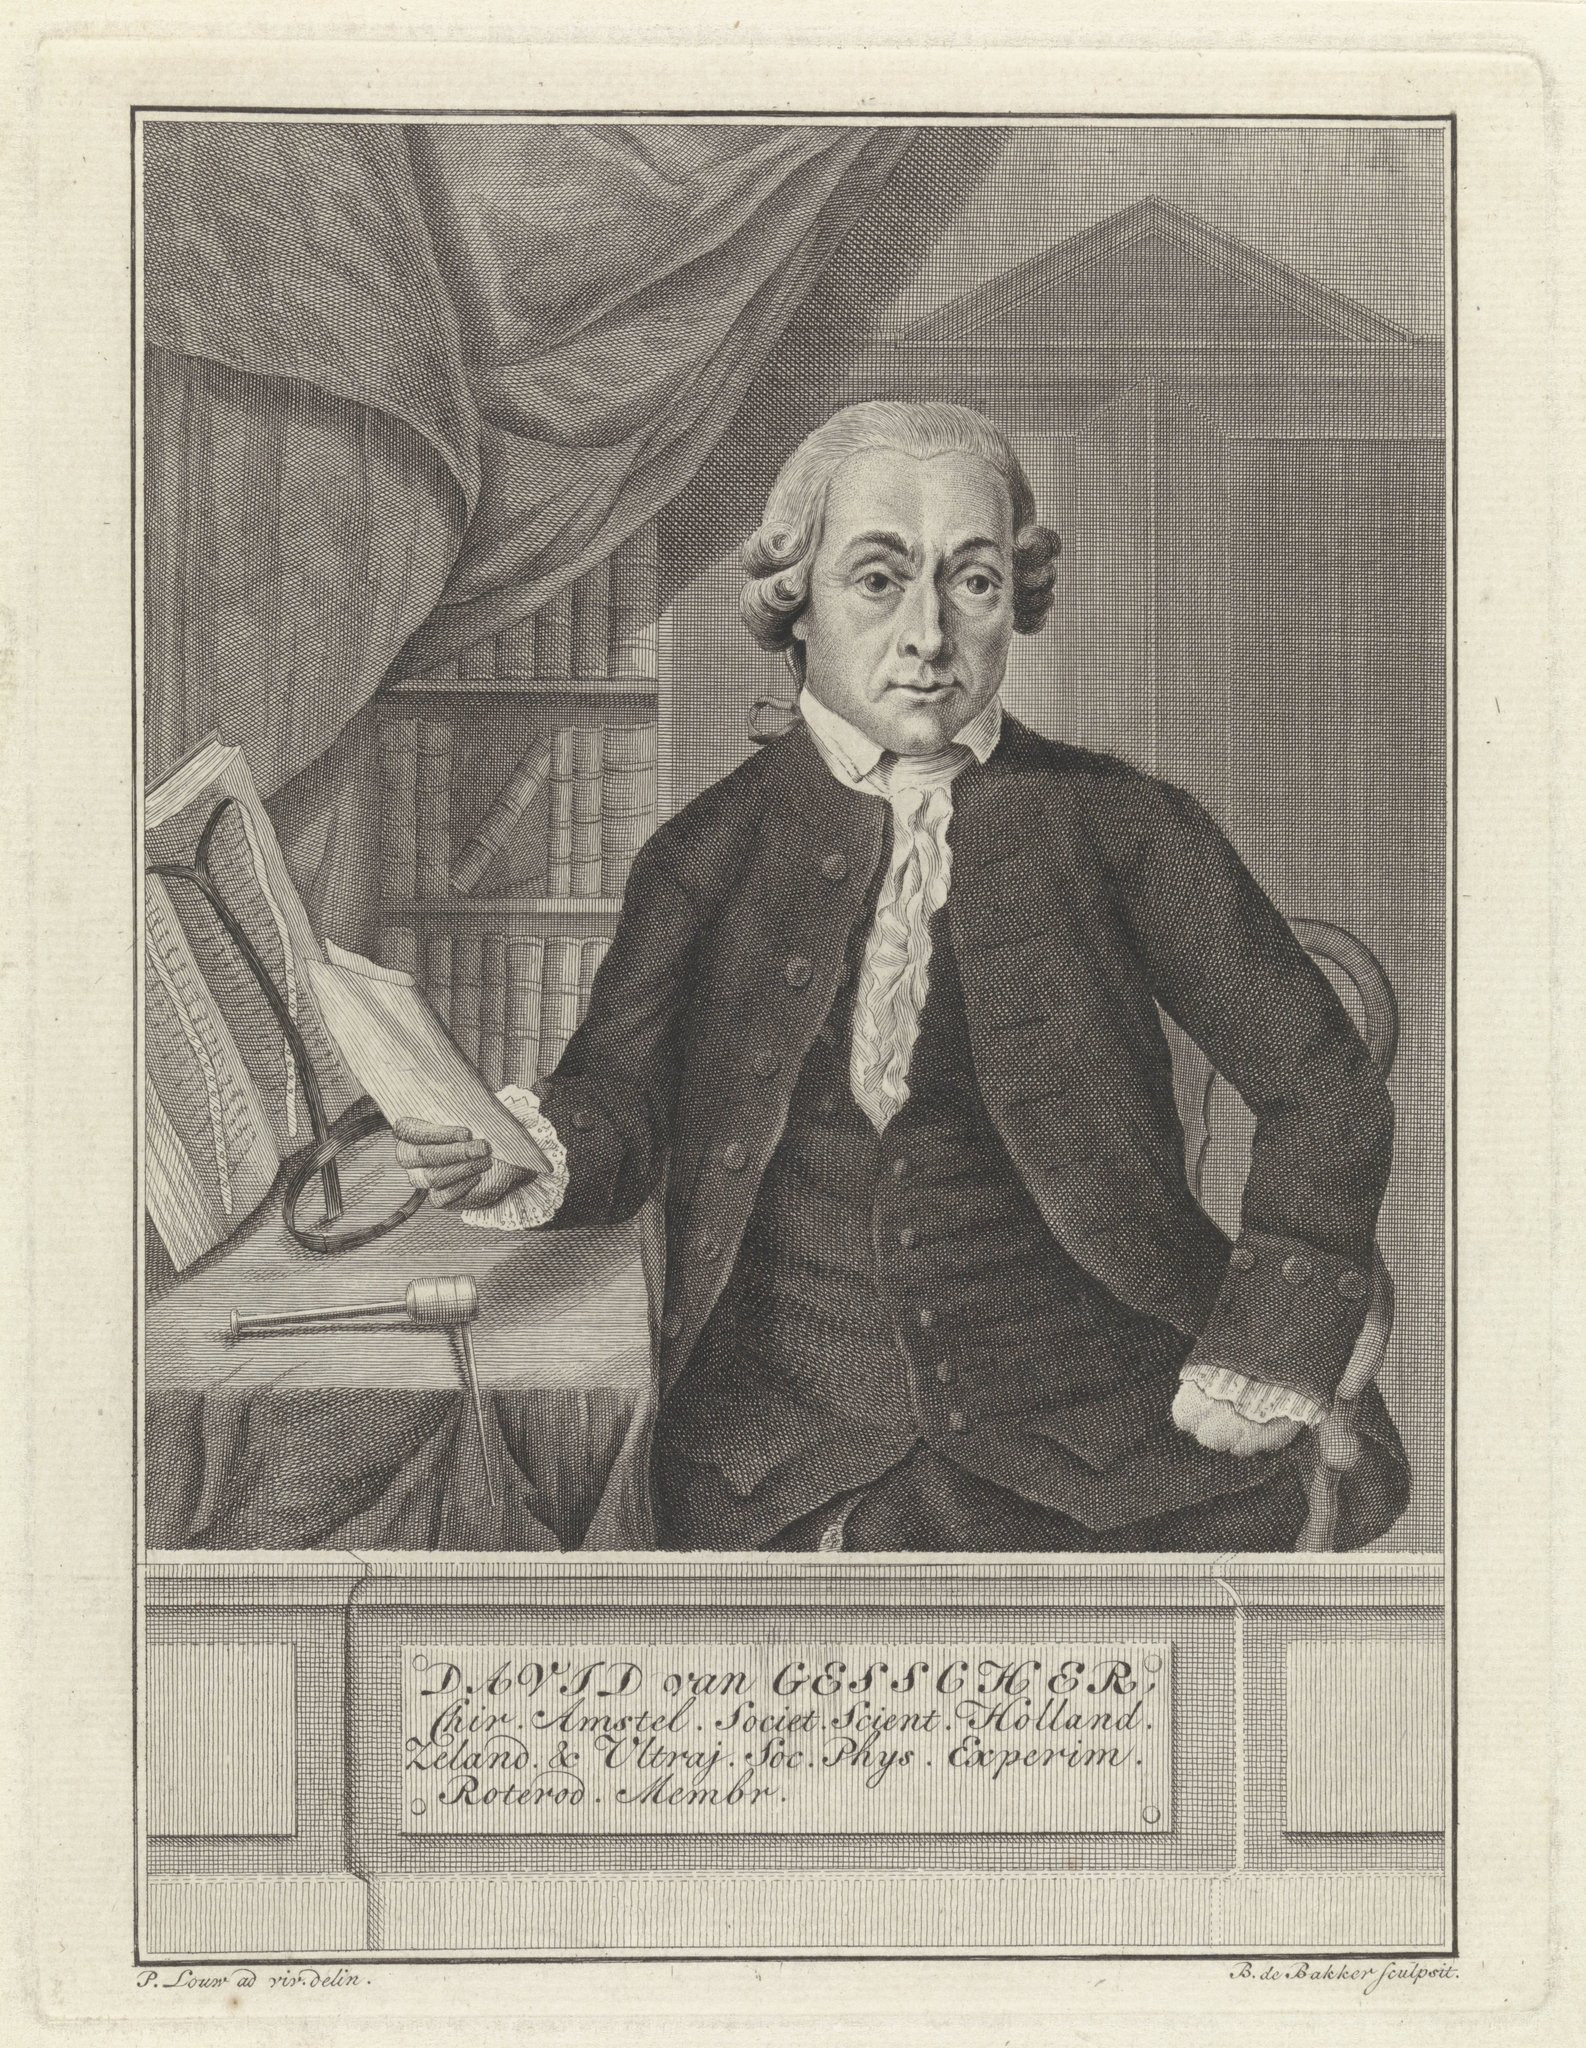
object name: print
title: David van gesscher (...) experim. roterod. membr.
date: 1762-1804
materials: paper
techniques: engraving, etching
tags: physician, doctor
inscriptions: collector's mark: Lugt 2228